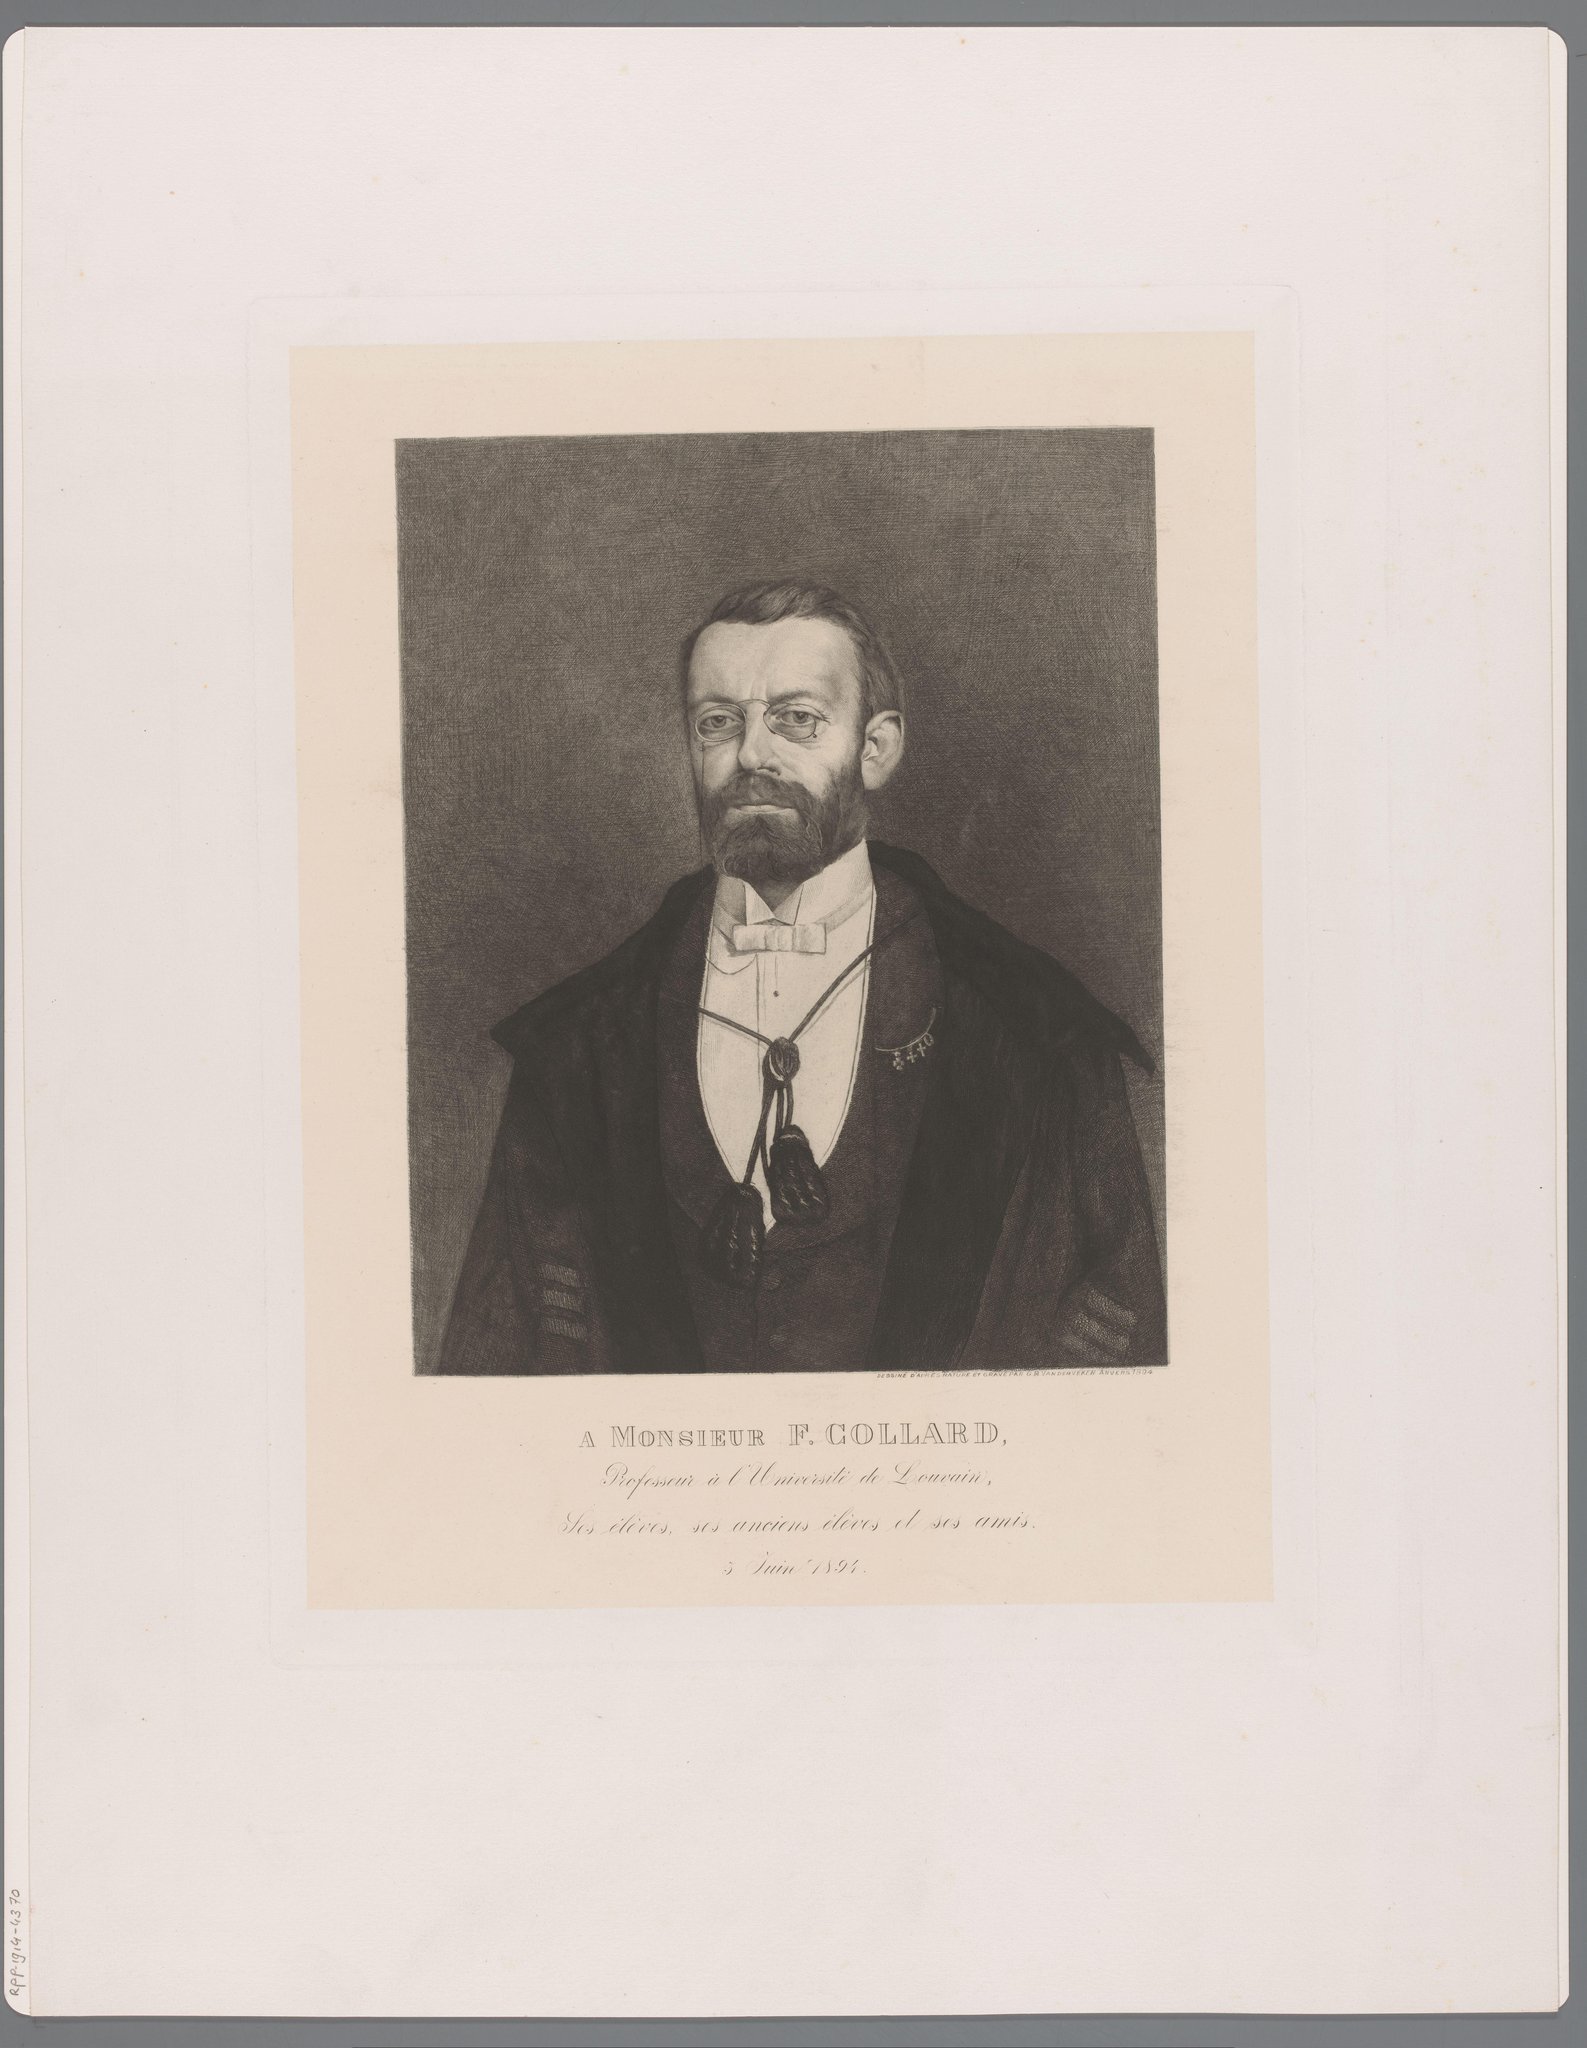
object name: print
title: Portret van François Collard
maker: willem philip van der veken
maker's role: print maker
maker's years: 1863-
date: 1894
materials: paper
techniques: etching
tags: eyeglasses, spectacles, adult man, historical persons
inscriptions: collector's mark: Lugt 2228